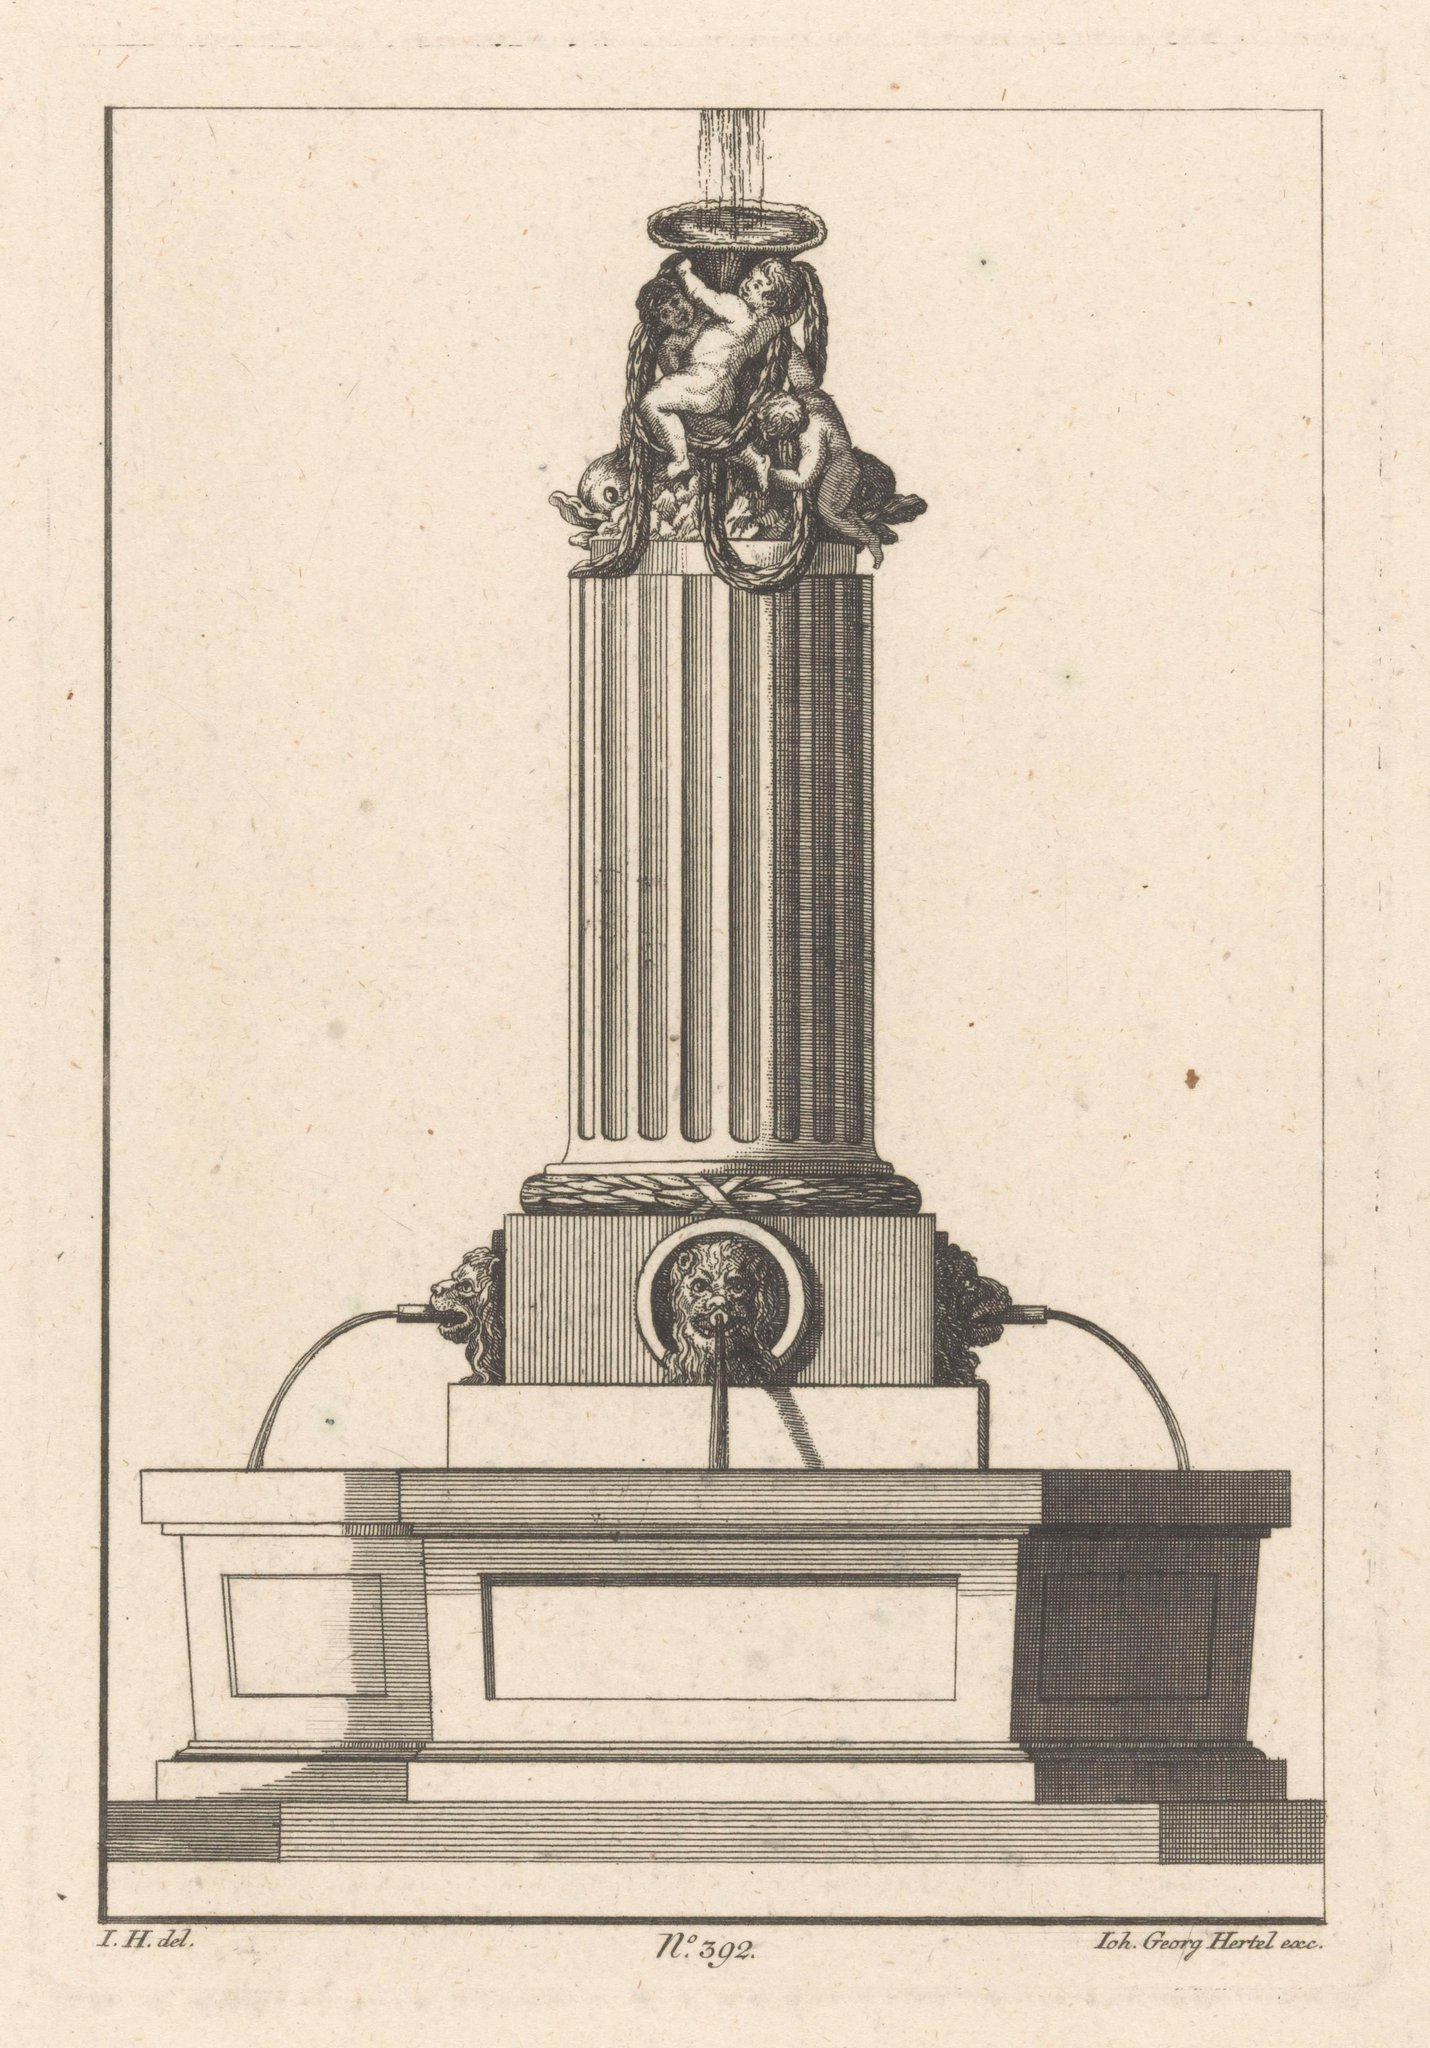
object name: ornament print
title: Fonteinen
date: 1770-1800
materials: paper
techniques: engraving, etching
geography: augsburg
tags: ornamental fountain, cupids: 'amores', 'amoretti', 'putti'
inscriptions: collector's mark: Lugt 2228, collector's mark: Lugt 2760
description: Ontwerp voor een fontein met drie uitlopers in de vorm van leeuwenkoppen. Drie putti met guirlandes, twee zeewezens en een fontein bekronen het geheel. Uitgeversnummer 392.